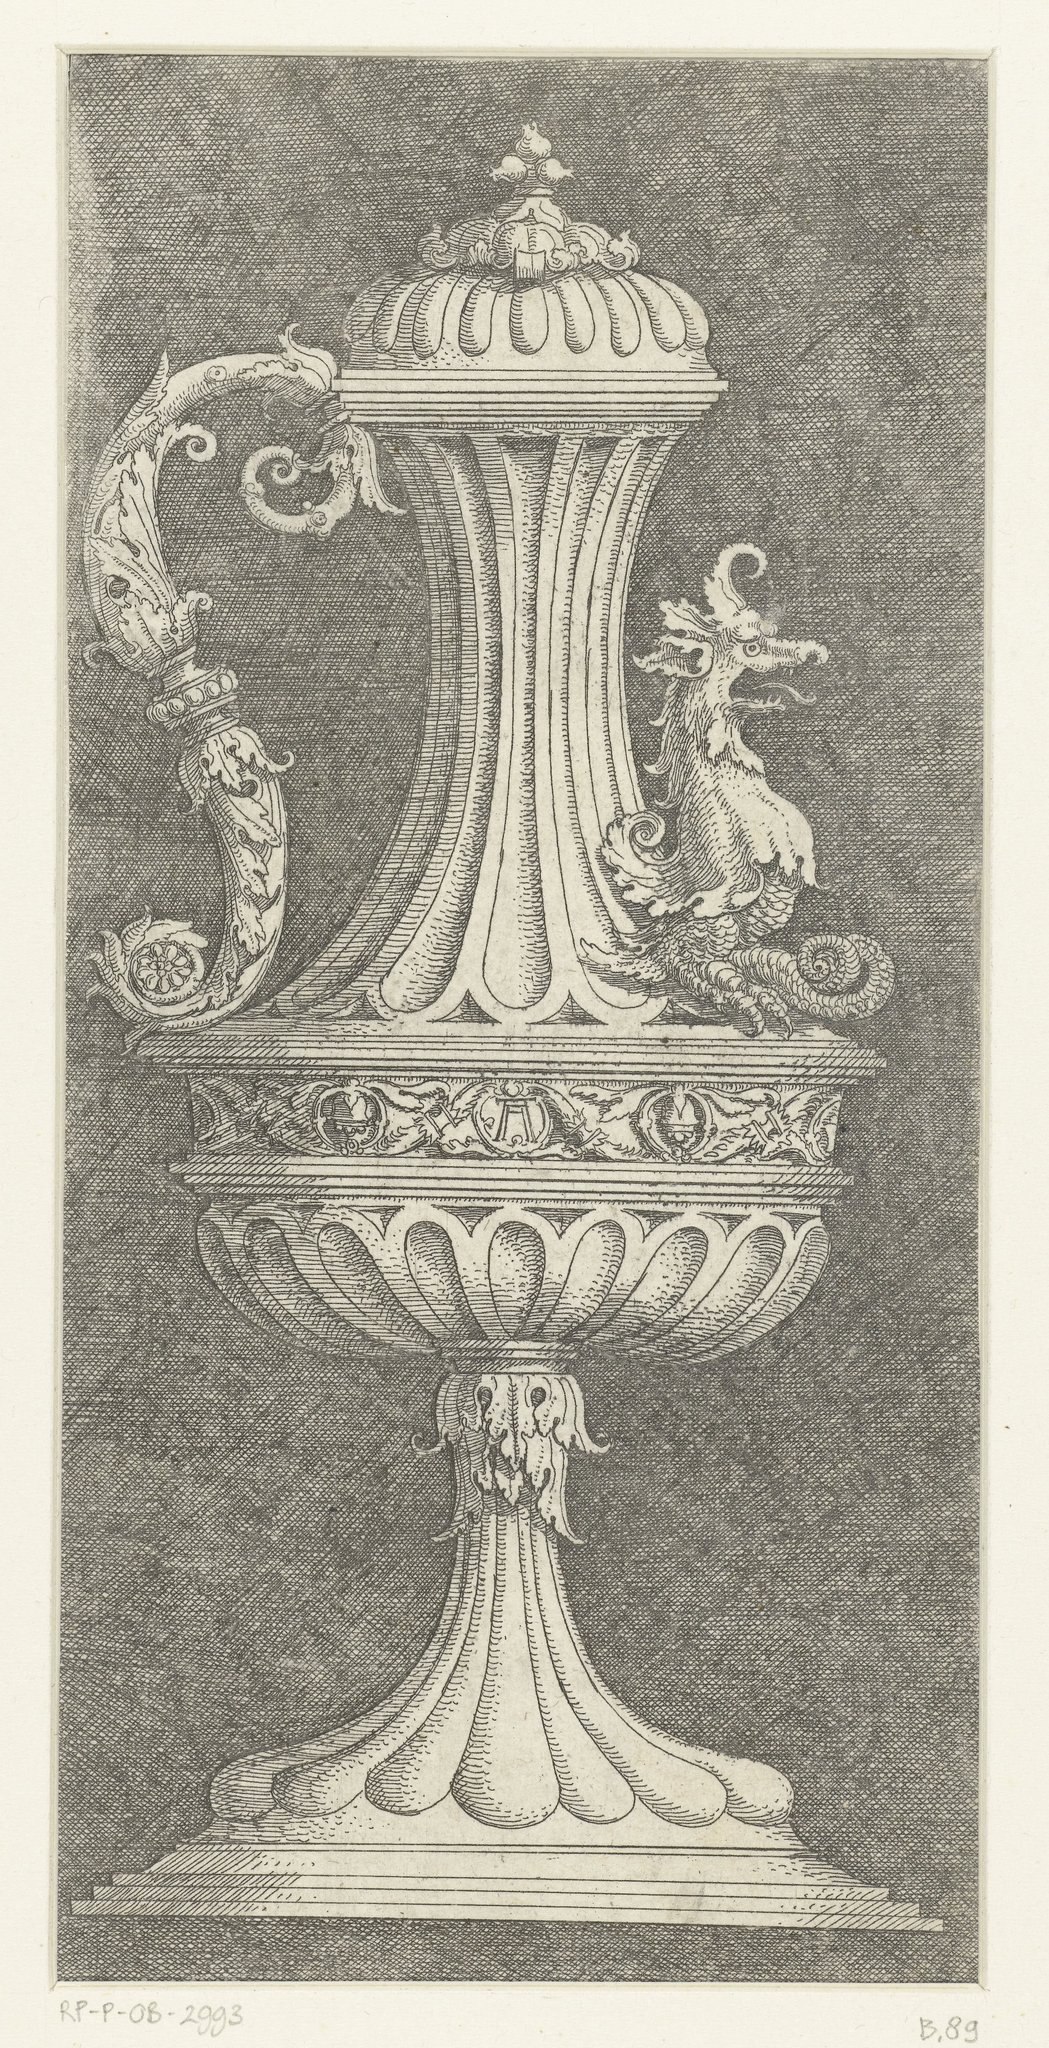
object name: print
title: Vazen, kannen en bokalen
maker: albrecht altdorfer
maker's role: draughtsman, print maker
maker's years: 1480-1538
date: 1506-1538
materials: paper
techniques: etching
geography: germany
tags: mug, beaker, goblet, dragon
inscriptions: number: ‘94’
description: Kan met handvat van bladranken aan de linkerzijde. Op de buik van de kan zit rechts een draak. Uit een serie van 22 bladen met vazen, kannen en bokalen.